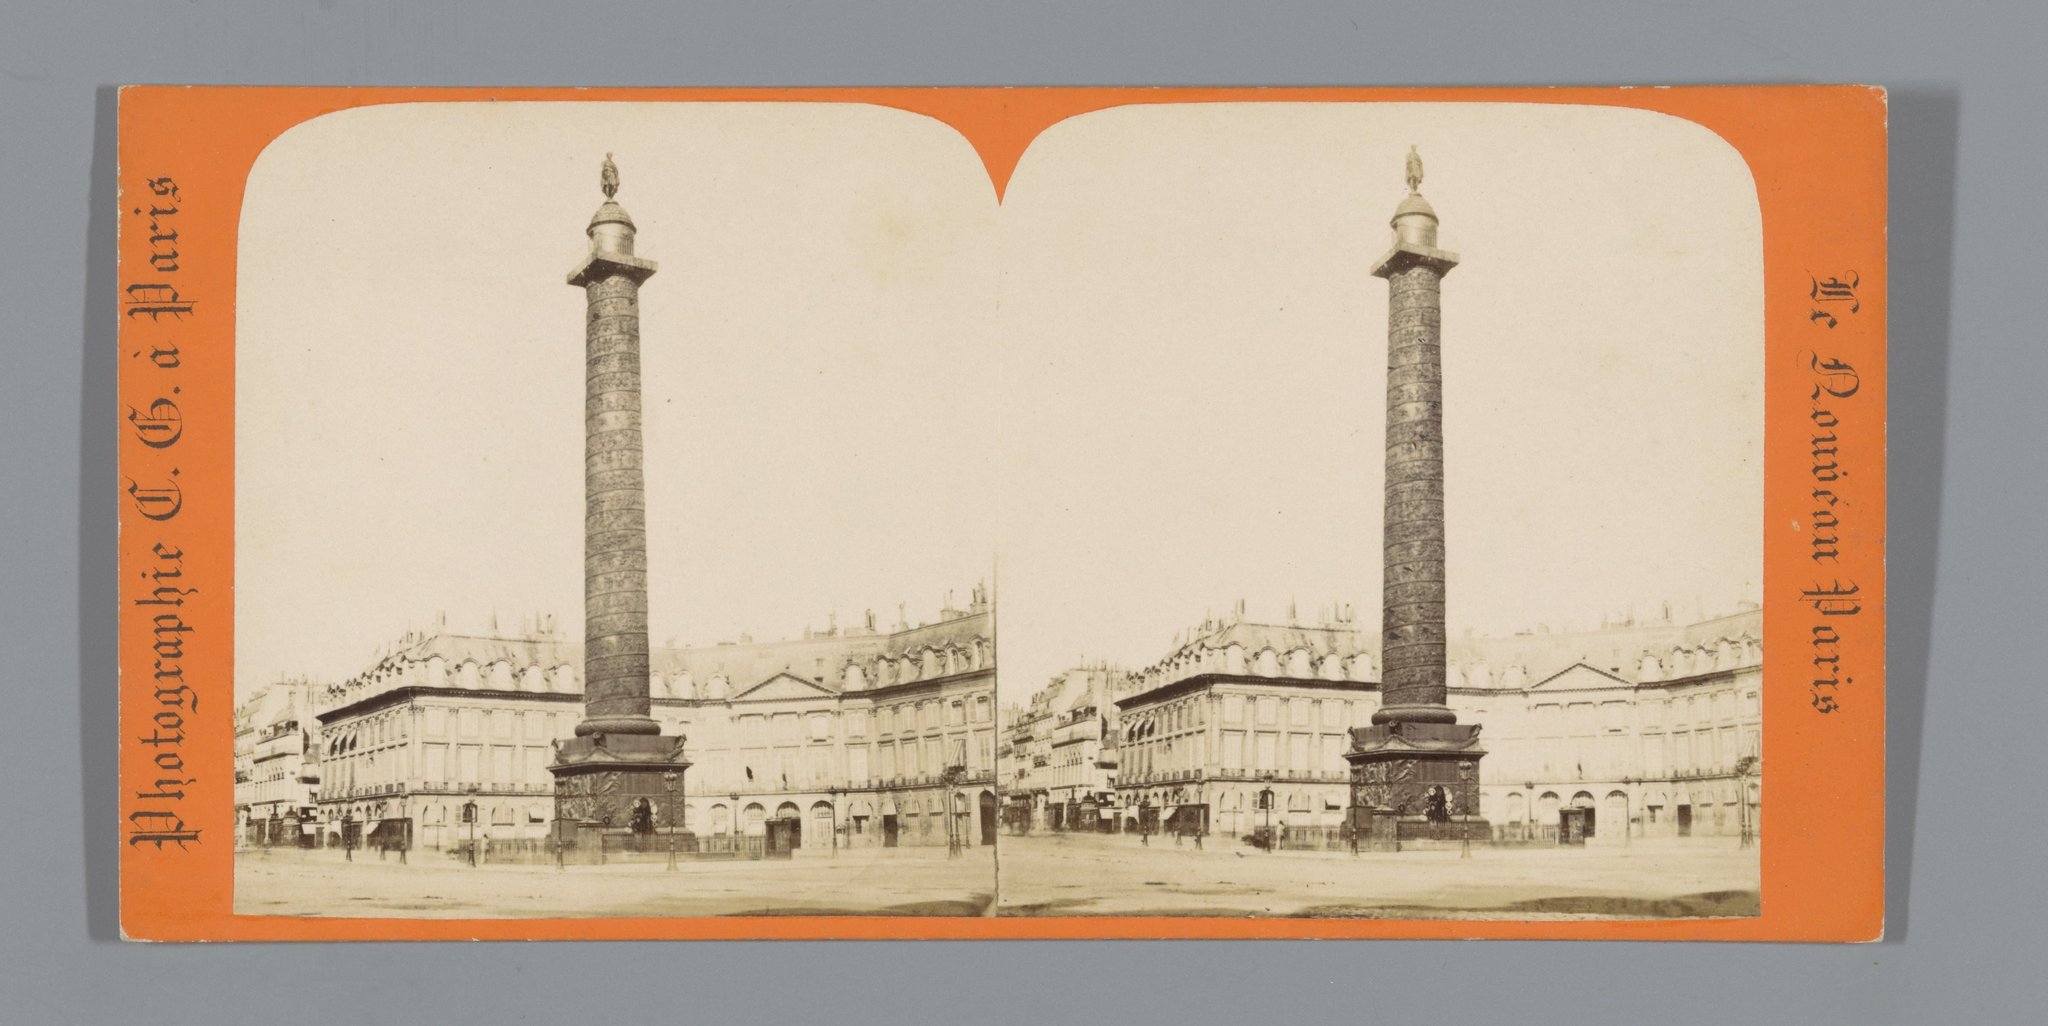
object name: stereograph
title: Le Nouveau Paris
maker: charles gérard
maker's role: fotograaf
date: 1850-1875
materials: cardboard, photographic support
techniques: albumen print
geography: place vendôme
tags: triumphal column with helical friezes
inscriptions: inscription: ‘Colonne vendome Paris’